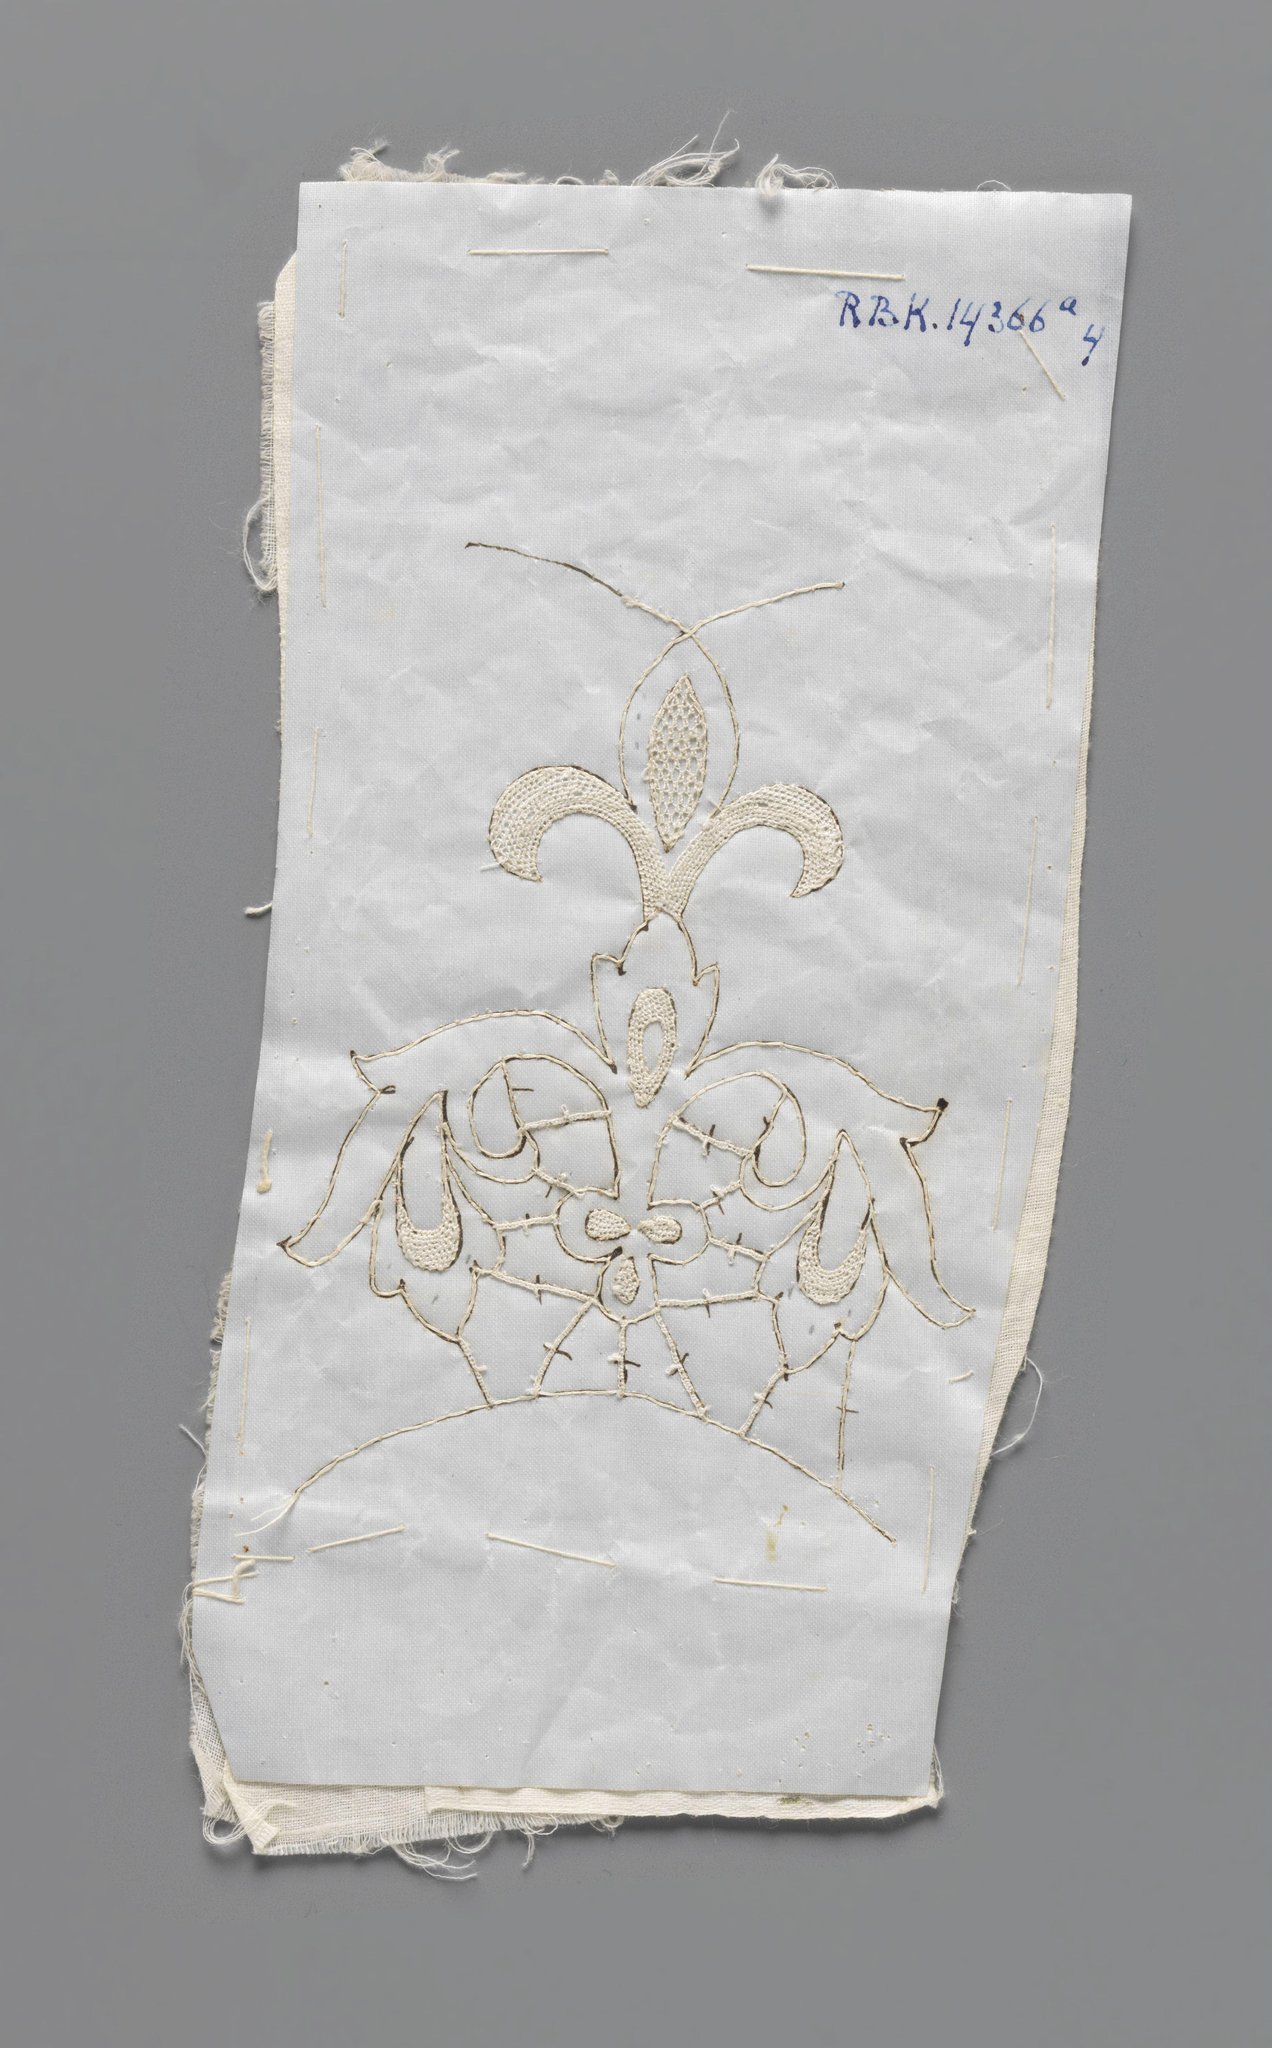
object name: lace pattern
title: Prikking vastgeregen op een dubbele lap katoen en met traceerdraden en naaldkantsteken voor het maken van een deel van een kraag van naaldkant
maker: johanna e. van nierop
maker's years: 1882-1970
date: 1915-1924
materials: cotton, paper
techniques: sewing, needlepoint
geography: amersfoort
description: Prikking voor een deel van een kraag van Venetiaanse naaldkant. Het naaldkantpatroon is met inkt getekend op lichtblauw papier en langs de patroonlijnen zijn vervolgens gaatjes geprikt. Door deze 'prikking' en de dubbele laag katoen is een traceerdraad genaaid. Sommige delen zijn al ingevuld met naaldkantsteken. Als alle naaldkantsteken over en tussen de traceerdraden gemaakt zijn kan de prikking en de katoenen ondergrond worden losgeknipt en verwijderd. Dan hou je alleen naaldkant over, in dit geval een deel van de kraag die dan met de andere delen en de rand tot kraag kan worden verwerkt. Het ontwerp van de kraag is gemaakt door een persoon uit België die in de Eerste Wereldoorlog was geïnterneerd in kamp 'Elisabeth-dorp' in Amersfoort. Mevrouw van Nierop is begonnen met het maken van de kraag en heeft de onafgewerkte delen geschonken aan het Rijksmuseum als studiemateriaal.